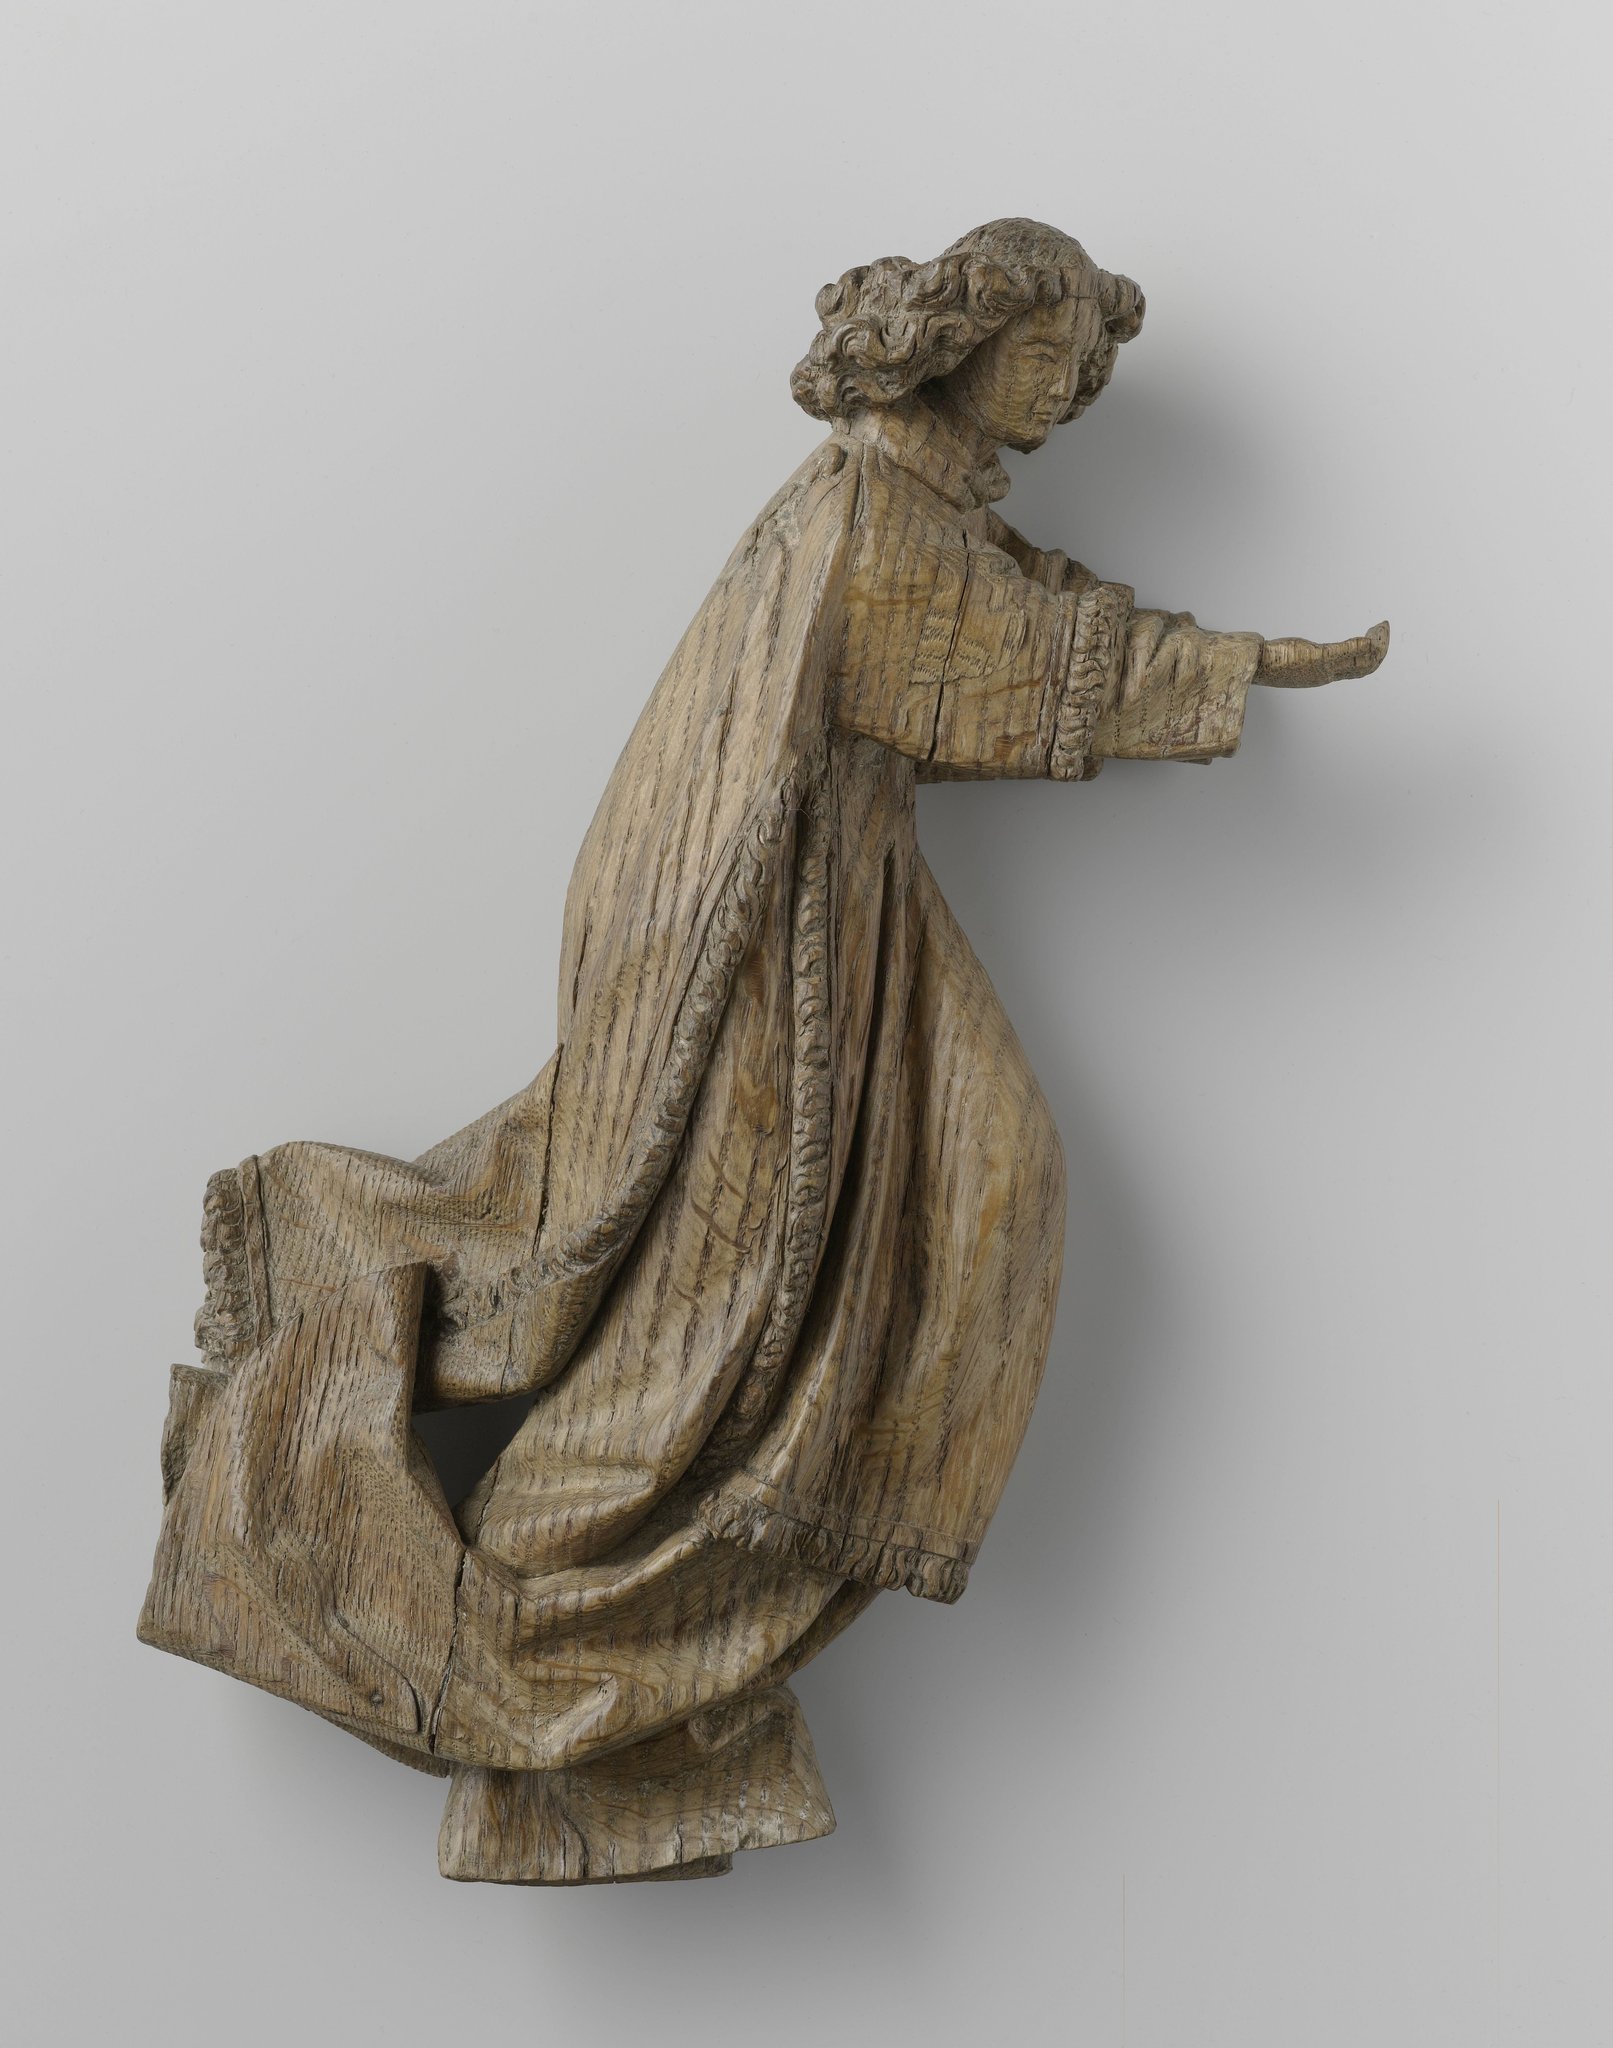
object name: sculpture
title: Hovering Angel, from a Calvary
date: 1500-1510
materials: wood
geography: brussels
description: Twee zwevende engelen. Eikenhout, ontdaan van polychromie. Brussel, ca. 1490.